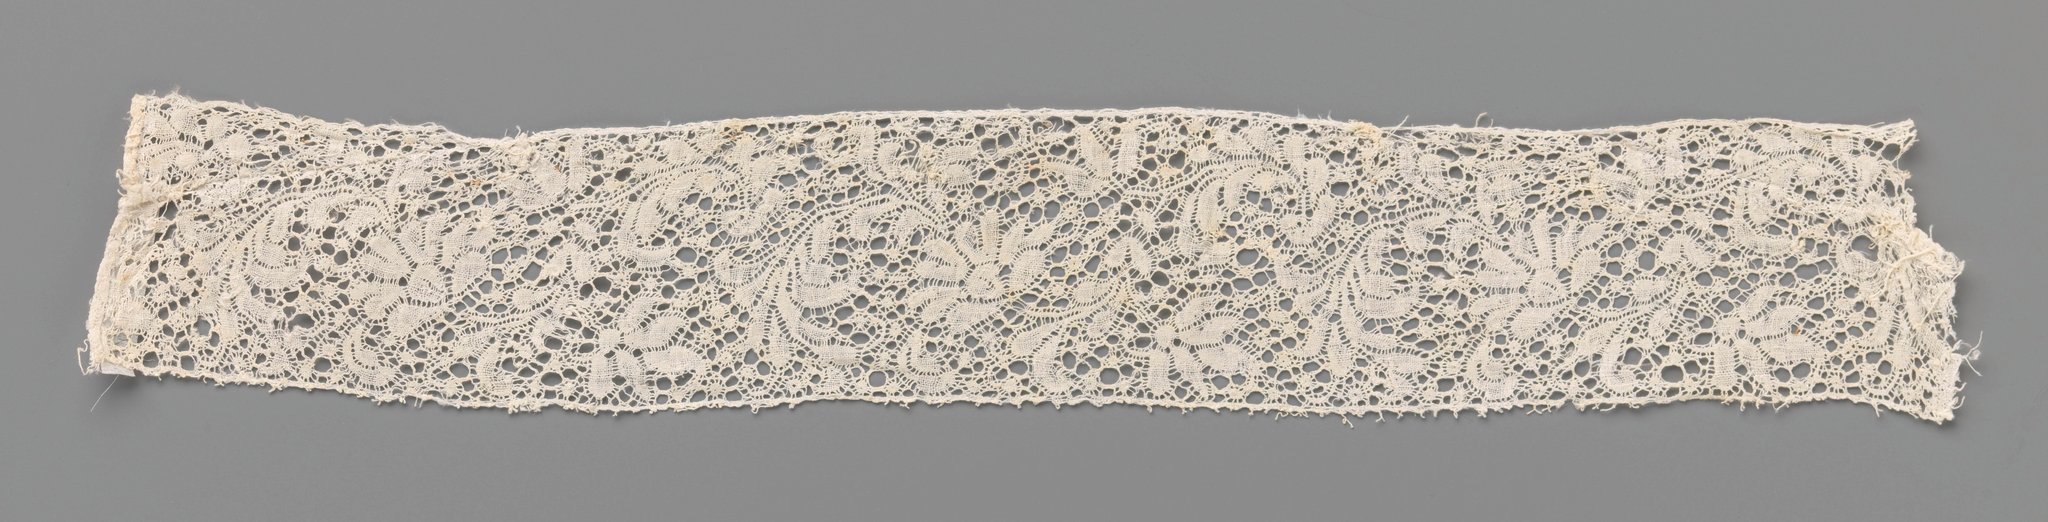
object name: strip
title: Strook kloskant met een golf van een waaiervormige bloem en gevederd blad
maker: Anonymous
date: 1720-1750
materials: linen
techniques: lace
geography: southern netherlands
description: Strook naturelkleurige kloskant, Binche-kant. Het zich herhalende patroon bestaat uit een gebogen bloemstengel met een omhoog gerichte waaiervormige bloem, waaruit een groot gevederd blad ontspringt dat naar de onderzijde afbuigt. Tussen de opeenvolgende losse golven die zo ontstaan, ligt langs de bovenzijde een tulp aan een gebogen stengel. Daaronder staat langs de onderzijde een losse bloem met aan één zijde vijf puntige bloemblaadjes. De motieven zijn met elkaar verbonden door een siergrond, een sneeuwvlokkengrond. De motieven zijn gemaakt in linnenslag met opengewerkte randjes. Boven- en onderzijde zijn recht afgewerkt, waarbij de onderzijde is voorzien van picots.